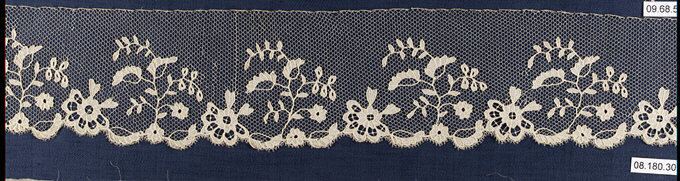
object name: fragment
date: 1801-1900